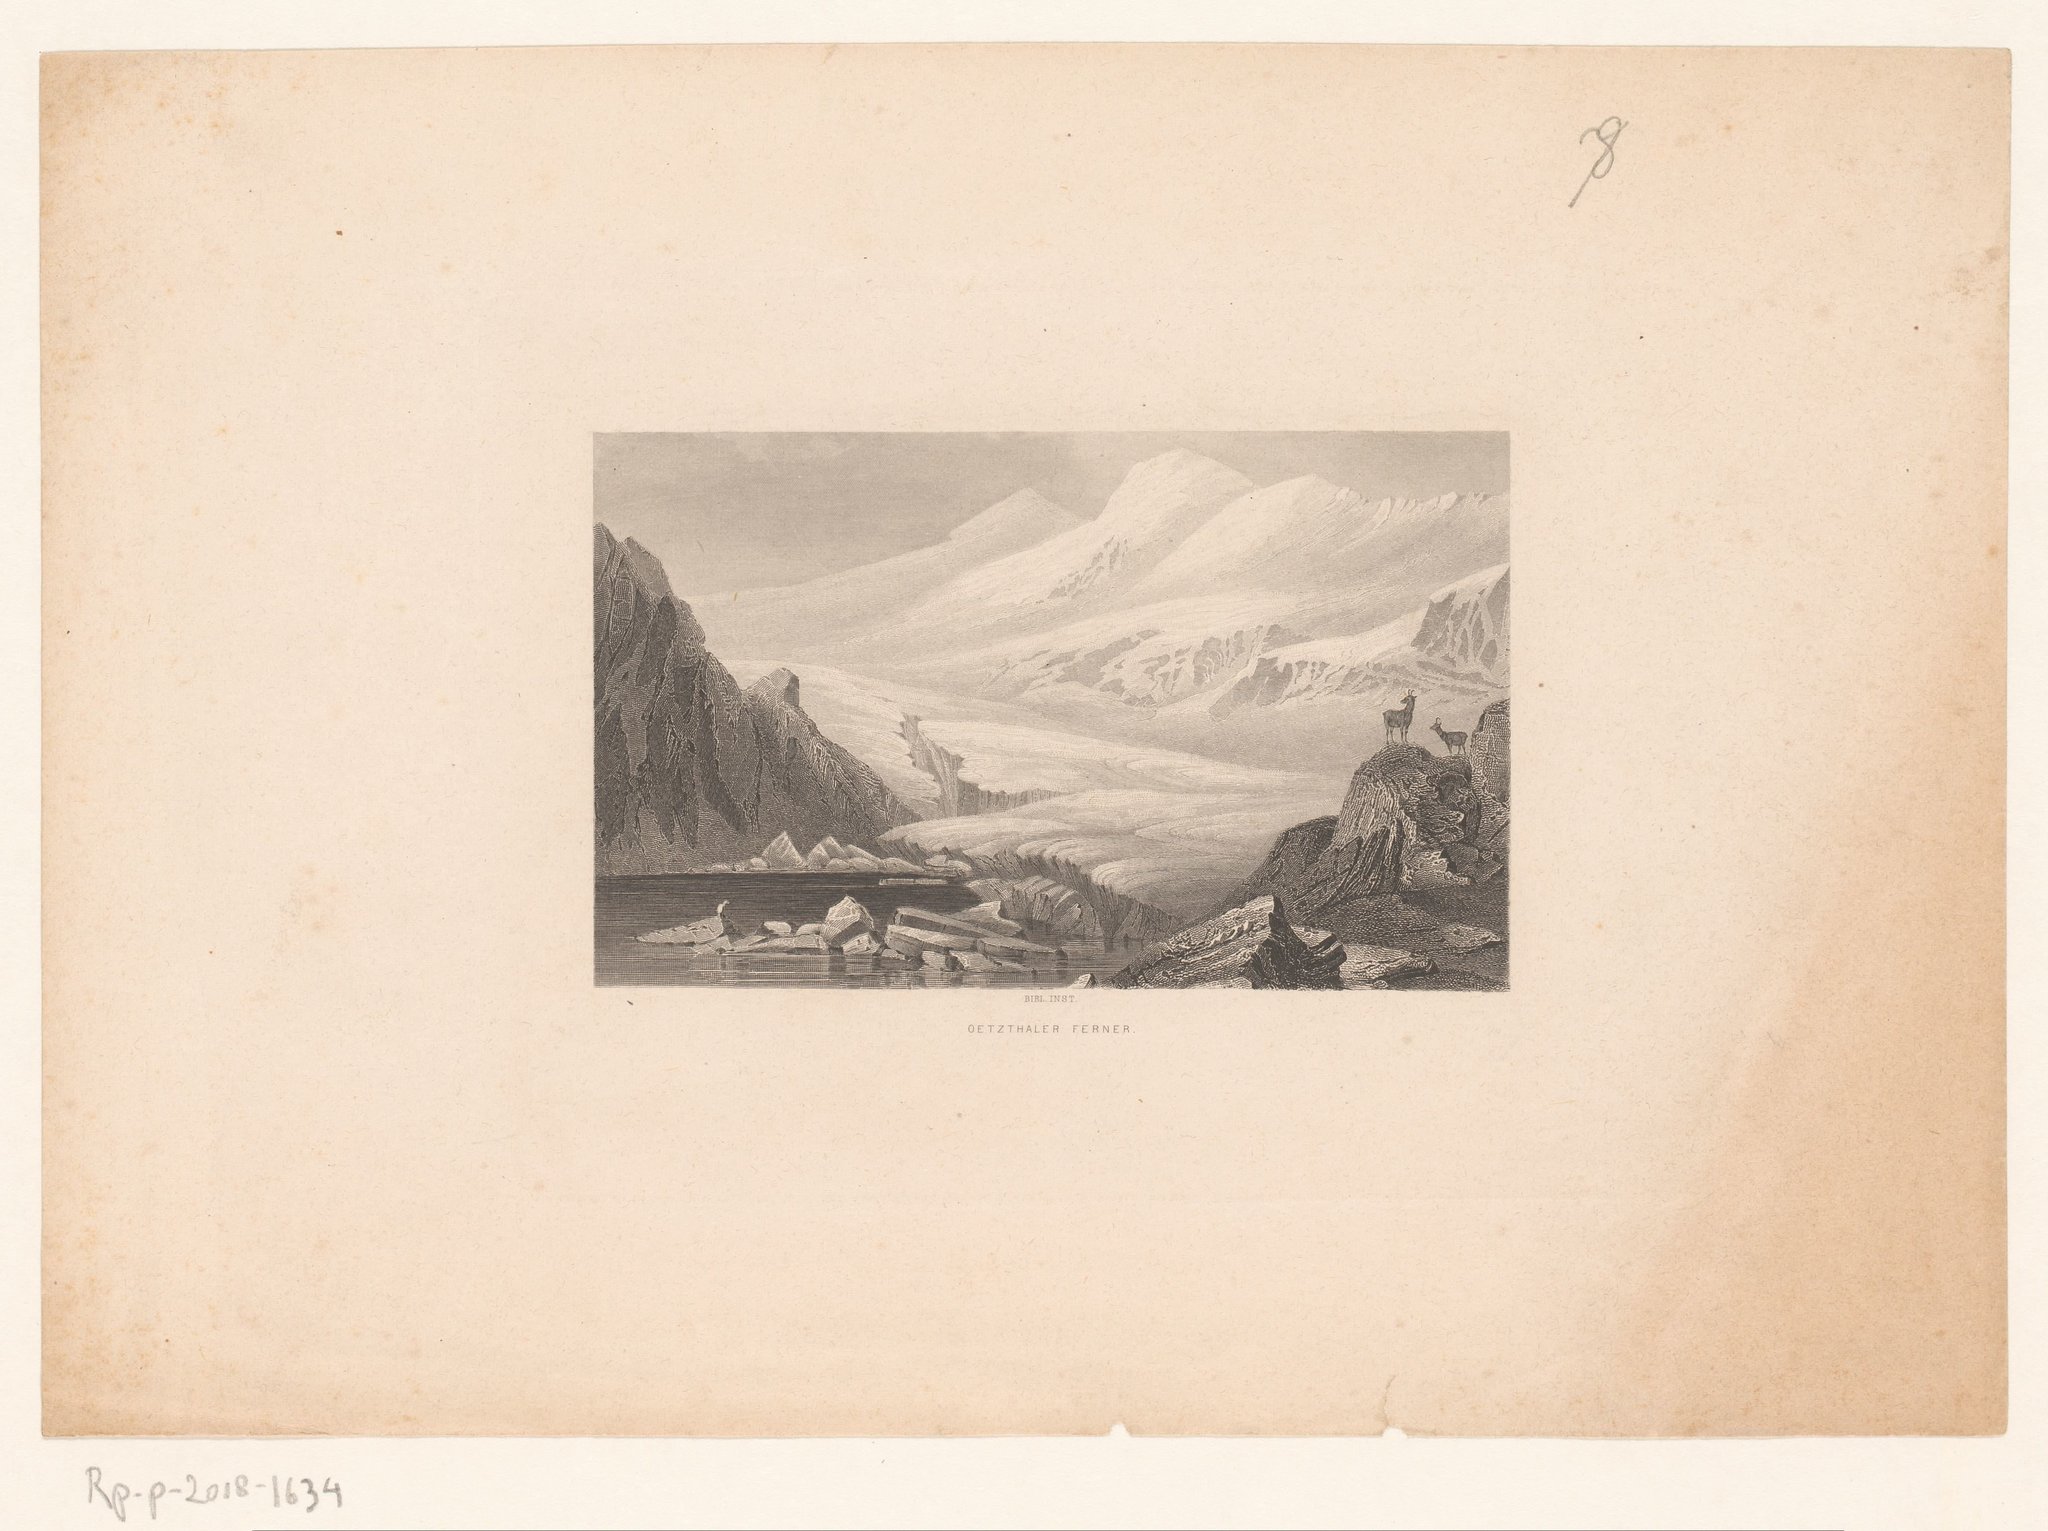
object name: print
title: Gezicht op de Gurgler Ferner, in Tirol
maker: Anonymous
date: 1826-1900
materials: paper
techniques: engraving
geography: hildburghausen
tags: glacier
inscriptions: collector's mark: Lugt 2228